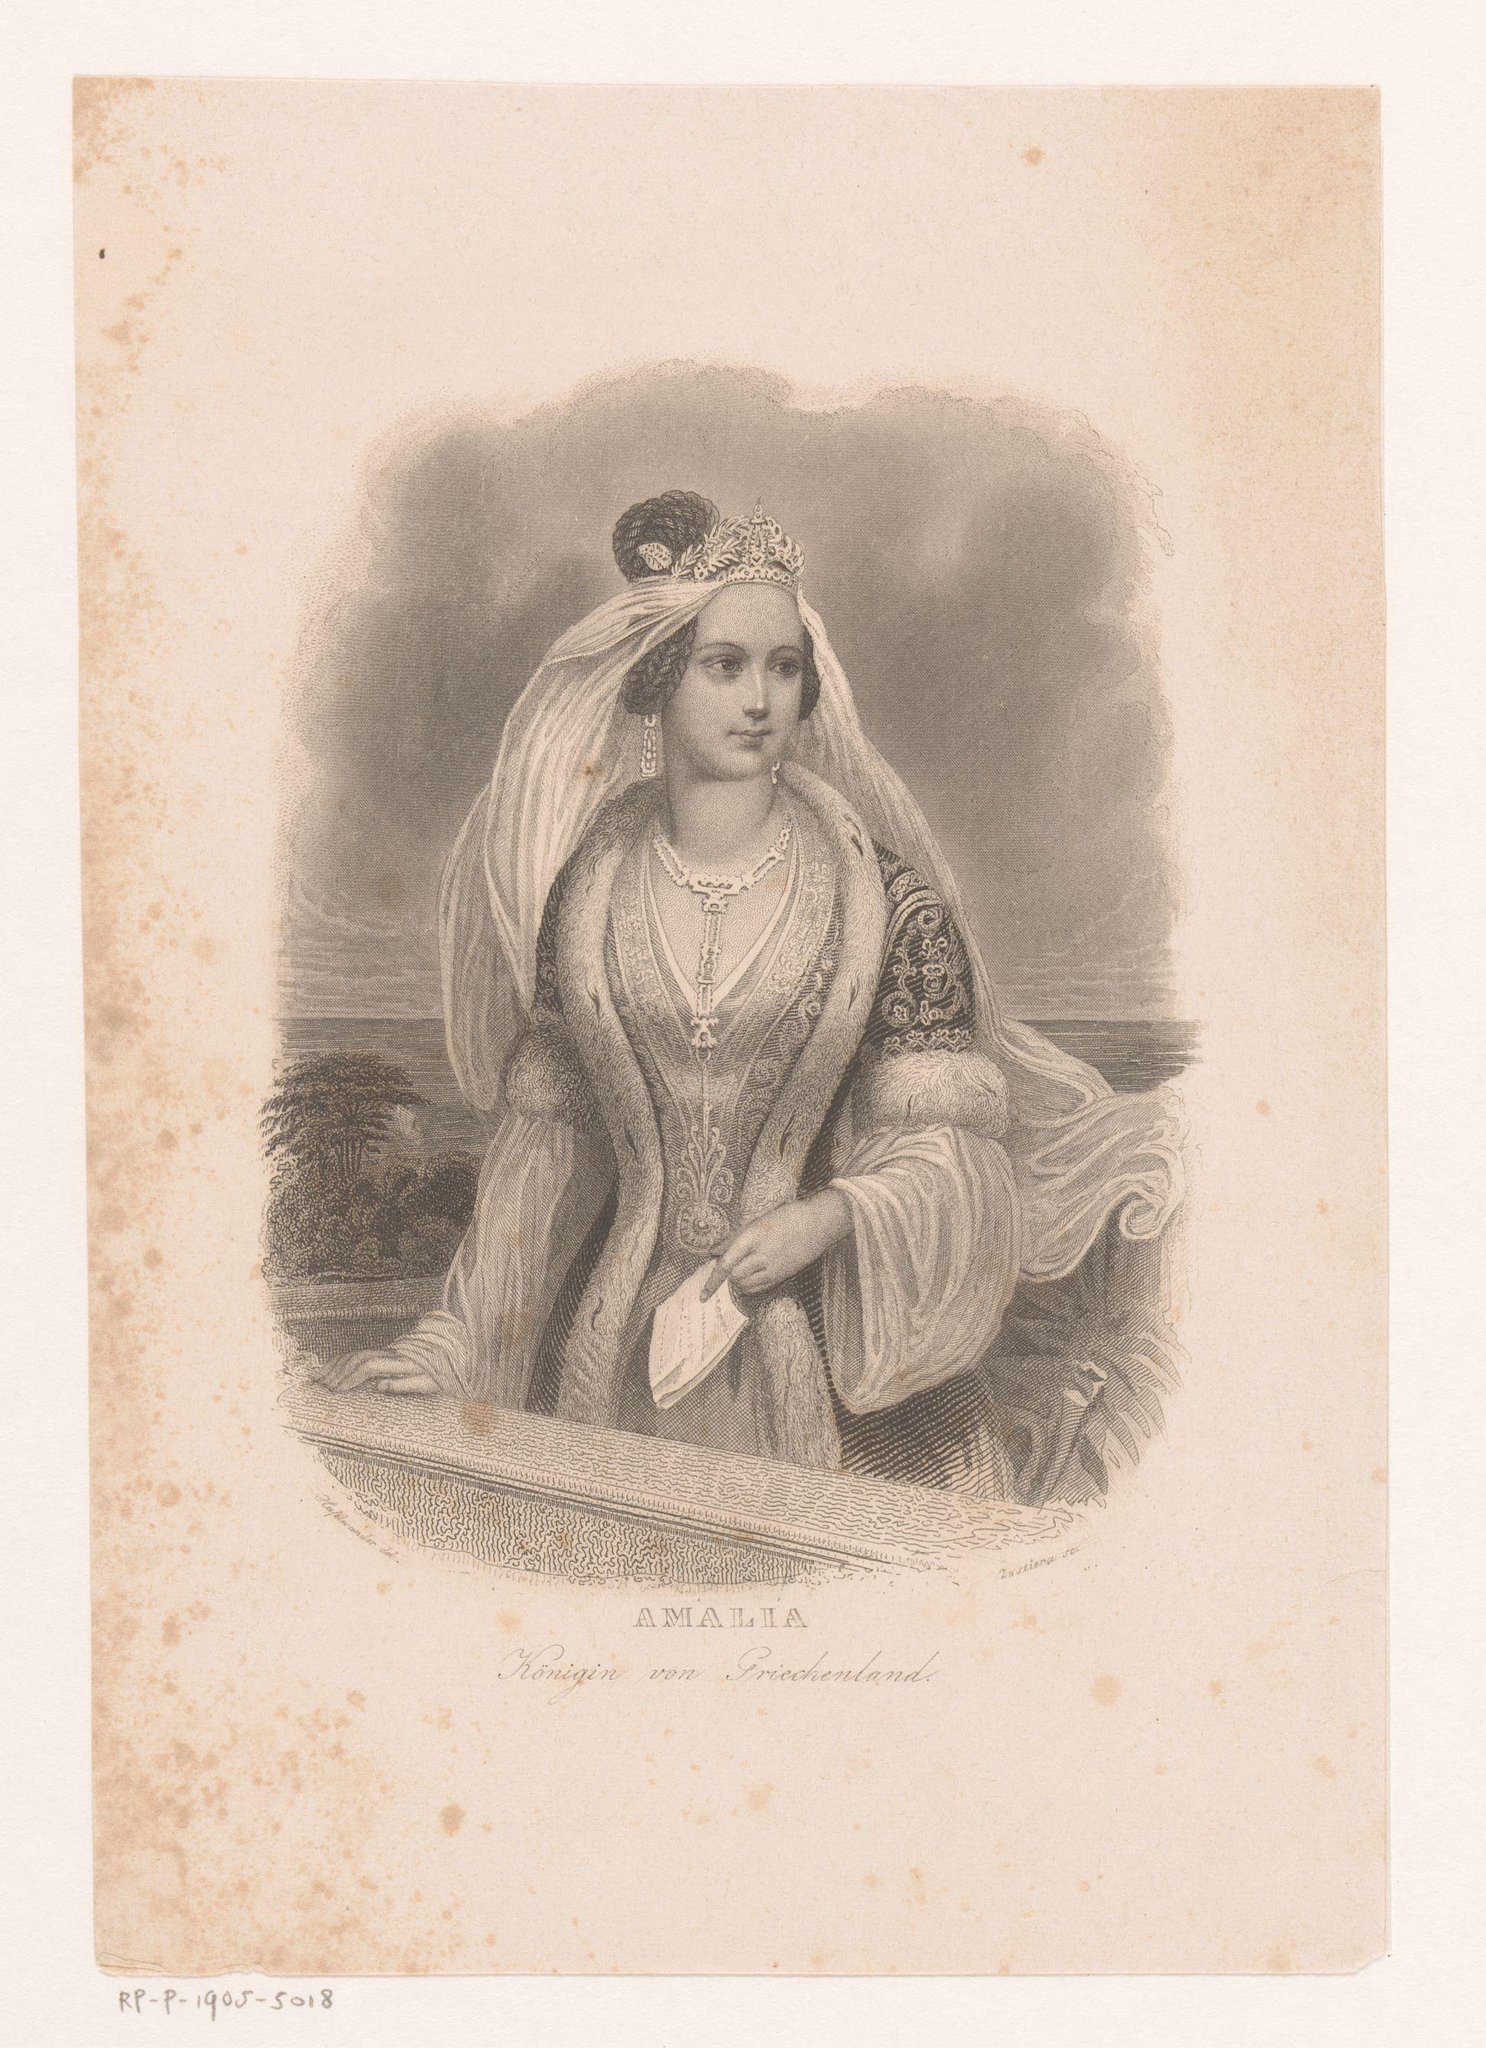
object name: print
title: Portret van Amalia van Oldenburg, koningin van Griekenland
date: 1836-1880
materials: paper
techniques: engraving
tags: historical persons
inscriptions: collector's mark: Lugt 2228